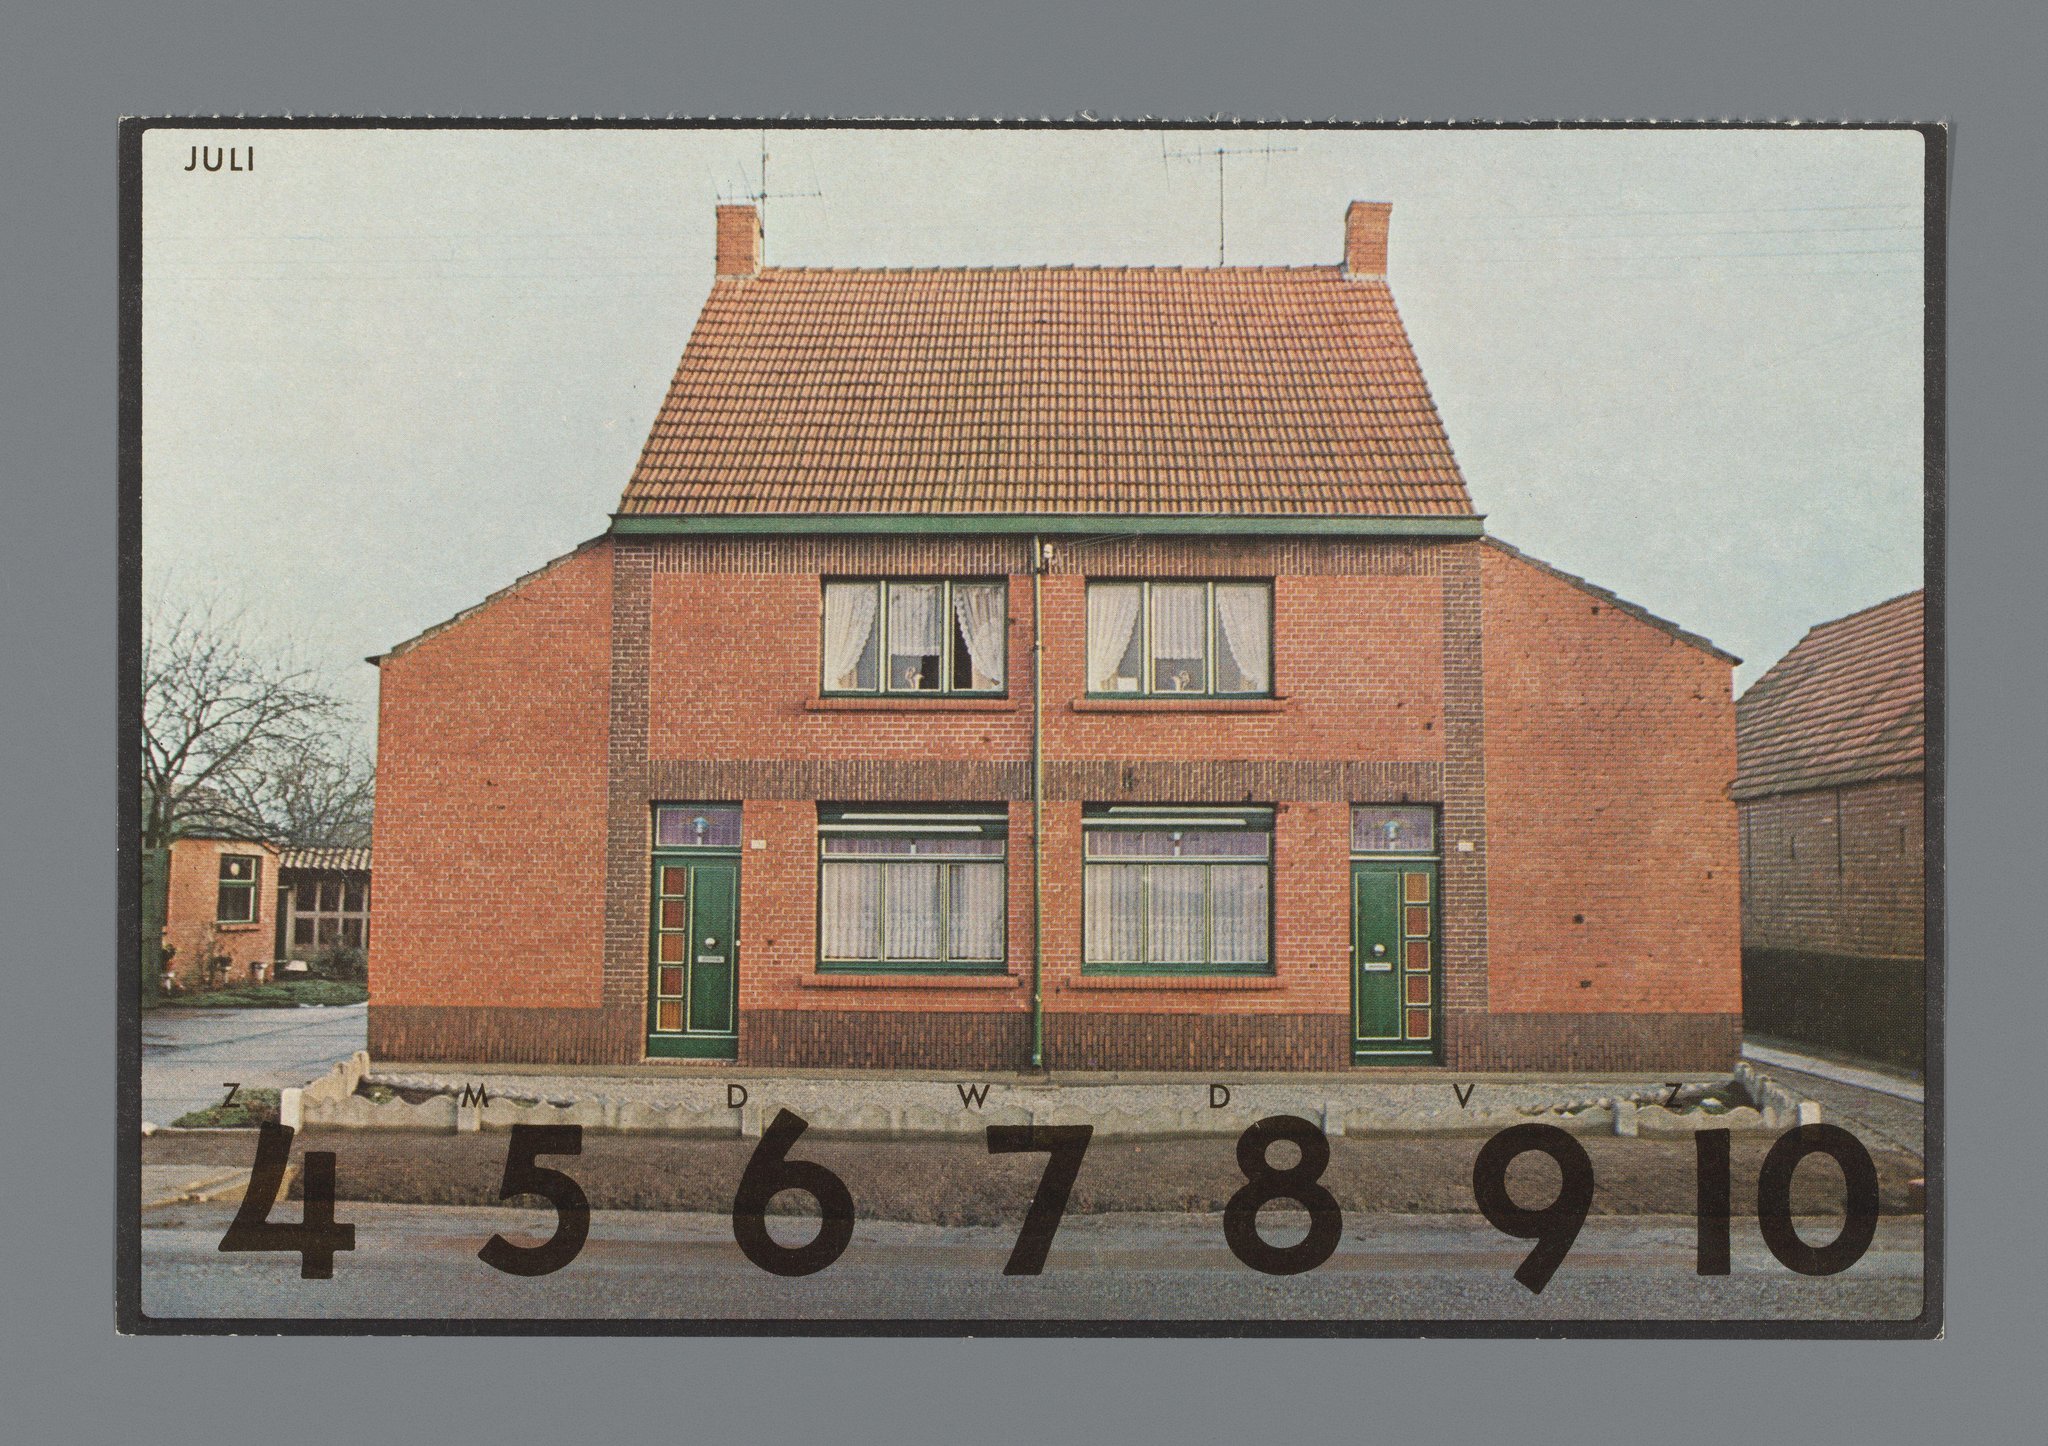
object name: photograph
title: België. Huizen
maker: Anonymous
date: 1900-1950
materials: paper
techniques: offset printed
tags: belgium